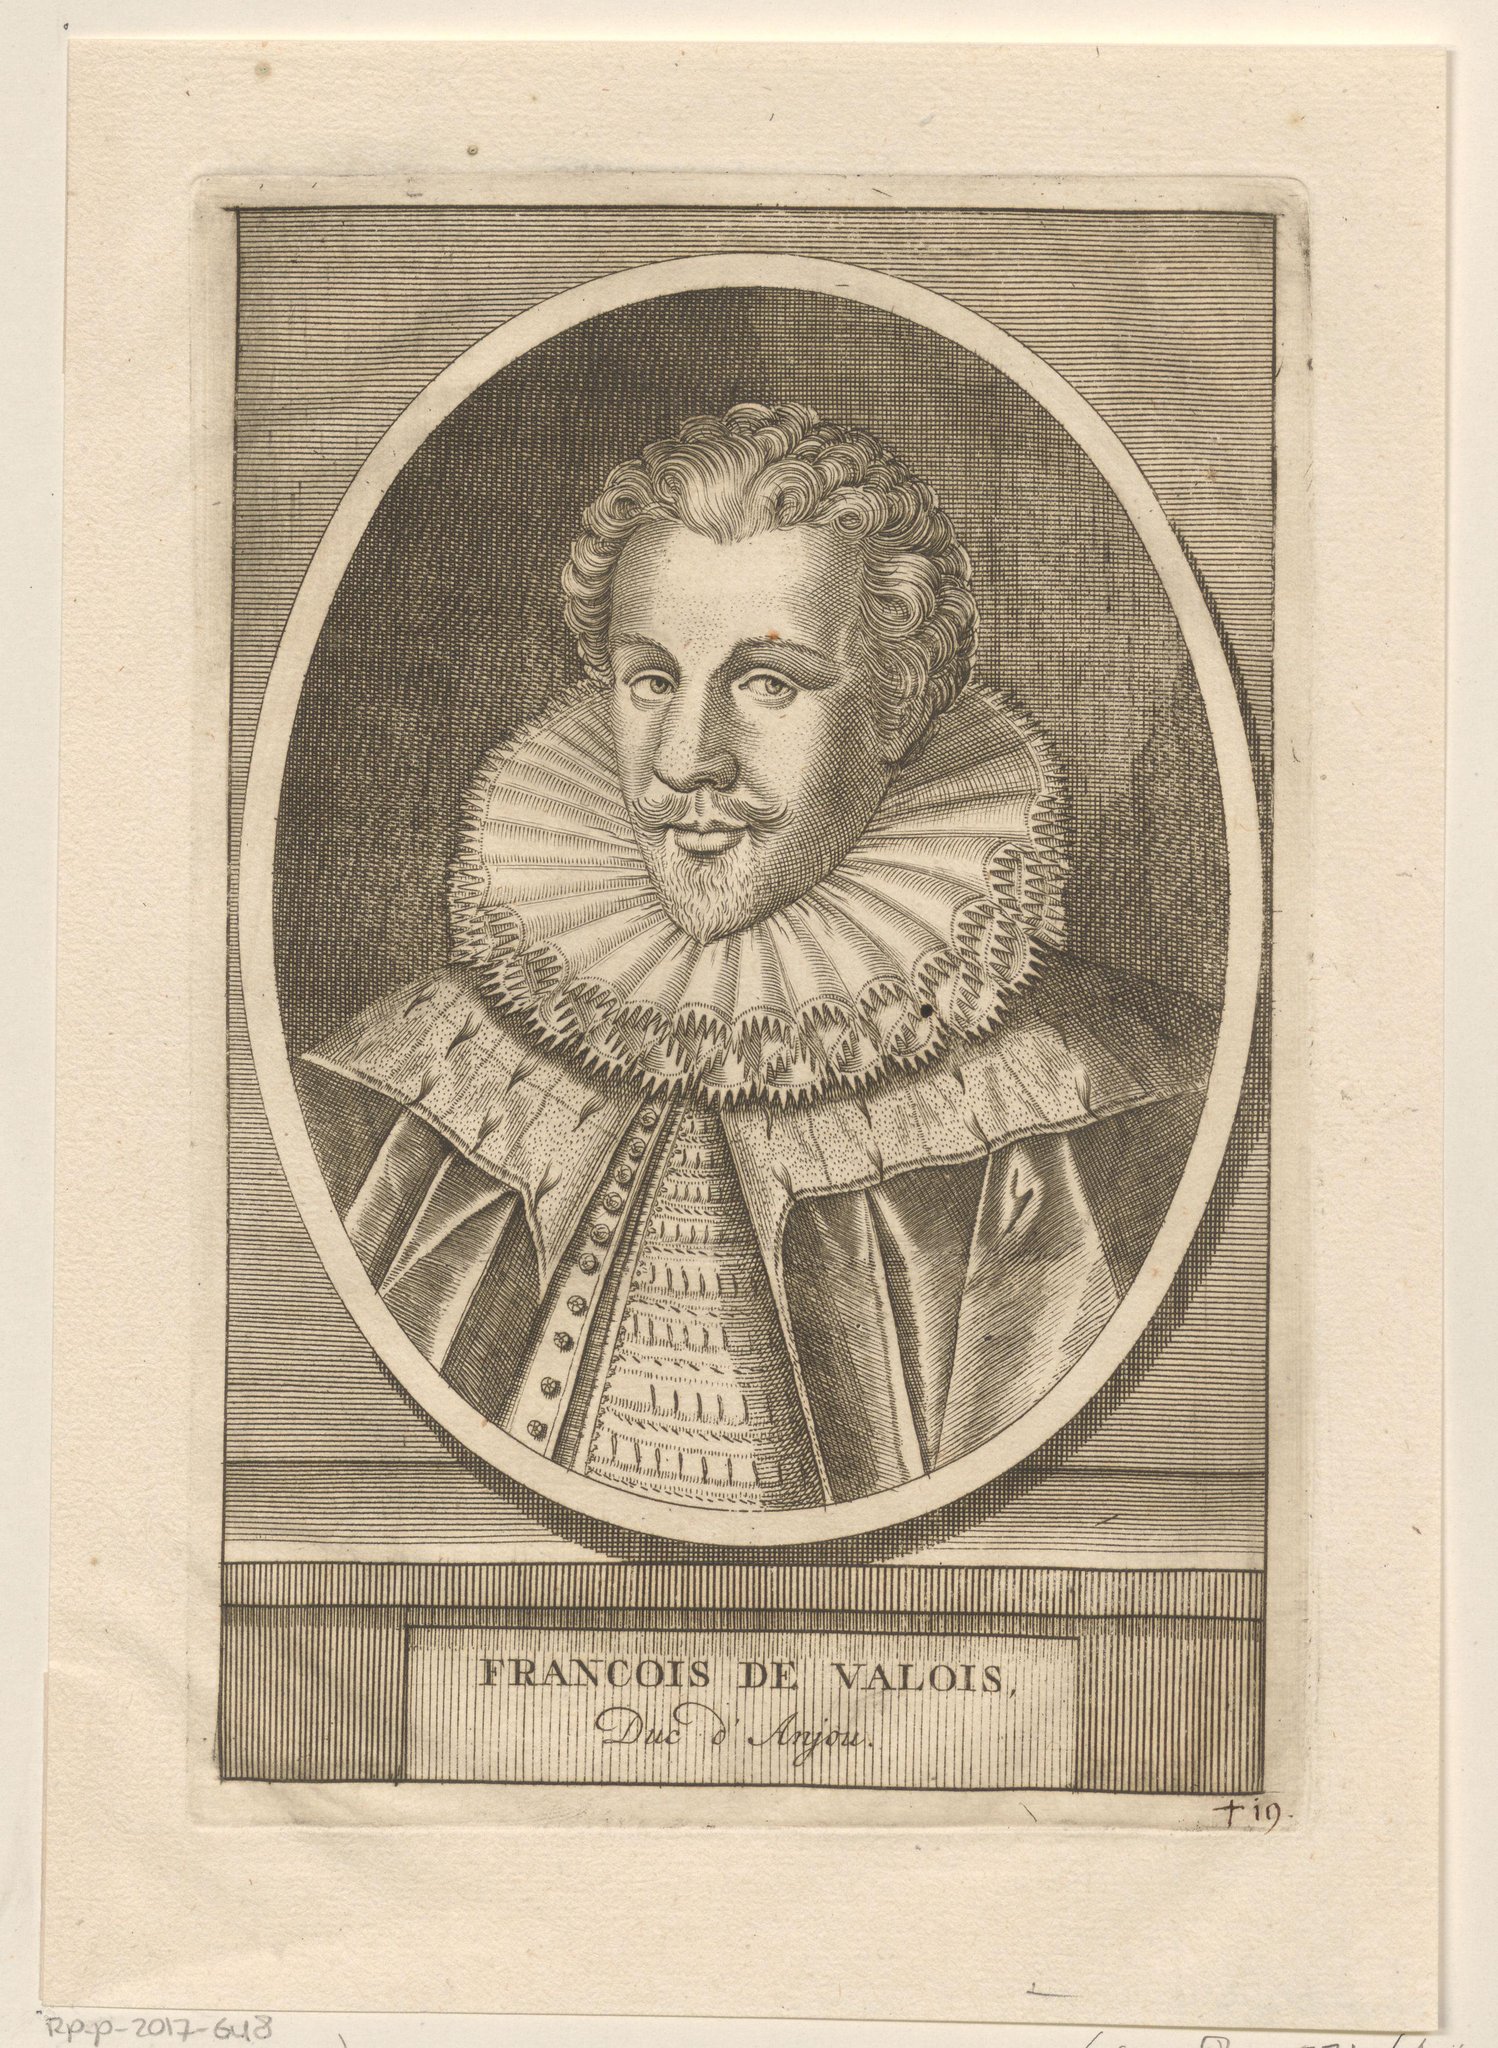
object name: print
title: Portret van François-Hercule de Valois, hertog van Anjou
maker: Anonymous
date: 1600-1699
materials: paper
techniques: engraving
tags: paris, françois-hercule de valois (hertog van anjou)